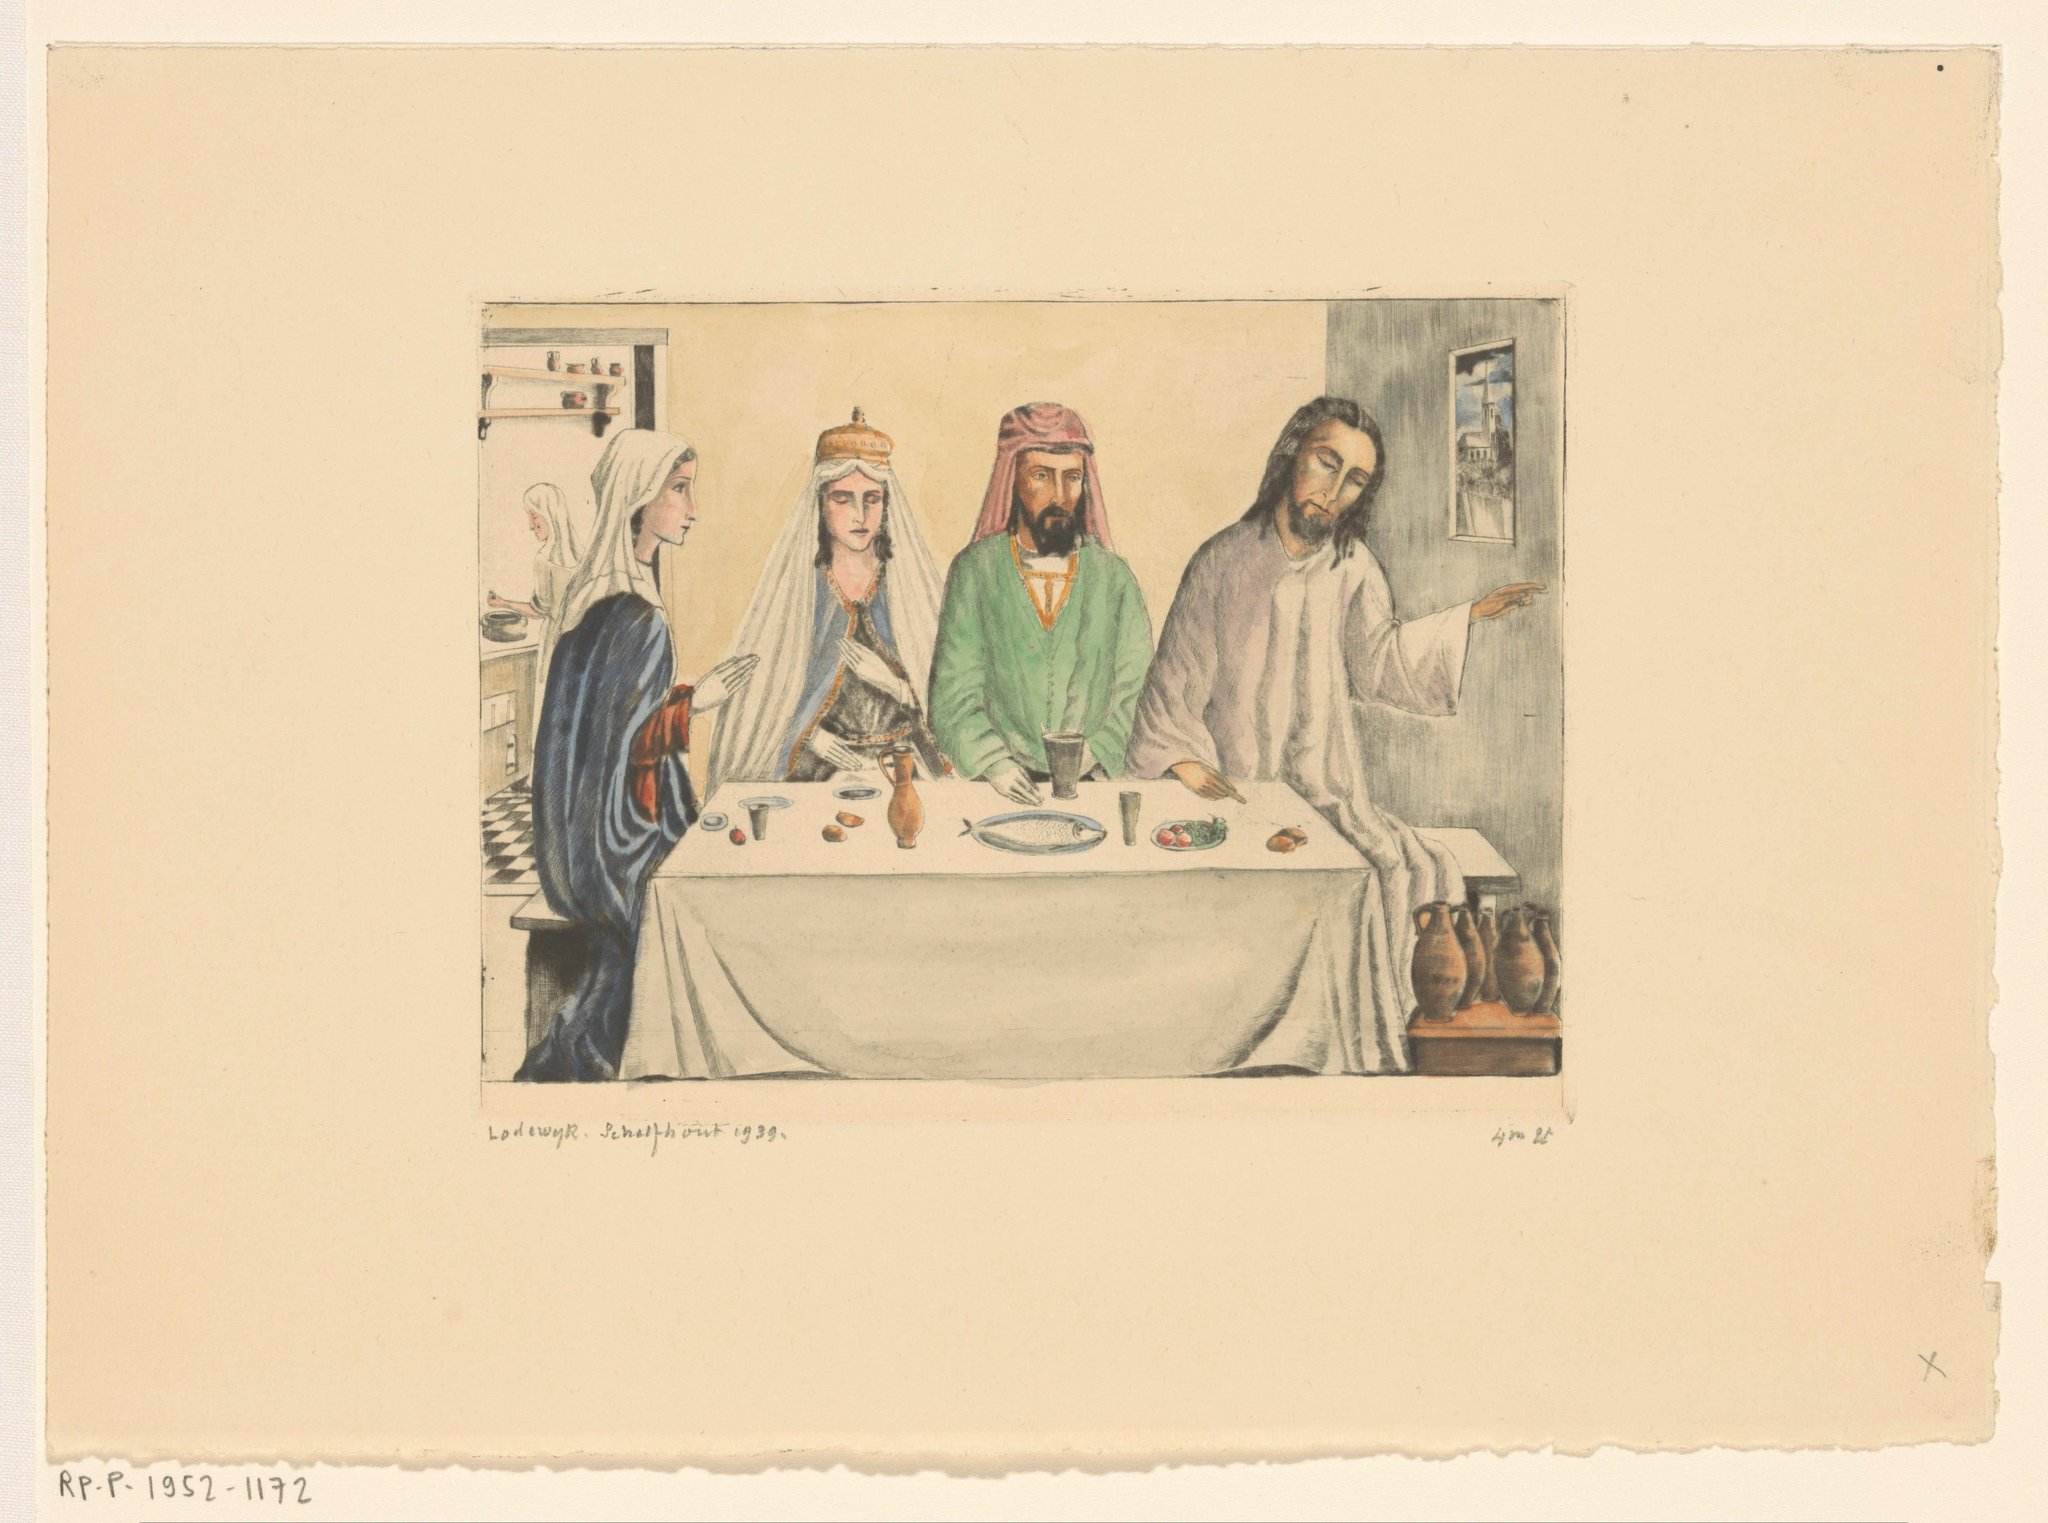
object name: print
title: Bruiloft te Kana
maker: lodewijk schelfhout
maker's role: draughtsman, print maker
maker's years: 1881-1943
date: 1939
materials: paper, watercolor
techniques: drypoint, hand coloring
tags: the marriage-feast at cana (john 2:1-11)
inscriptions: collector's mark: Lugt 2228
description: Maria, een bruid en bruidegom, en Christus, gezeten aan een tafel. Christus zegent zes stenen wijnvaten, waardoor de inhoud ervan veranderd van water in wijn. Op de achtergrond een vrouw in een keuken en een raam dat uitzicht biedt op een kerk.